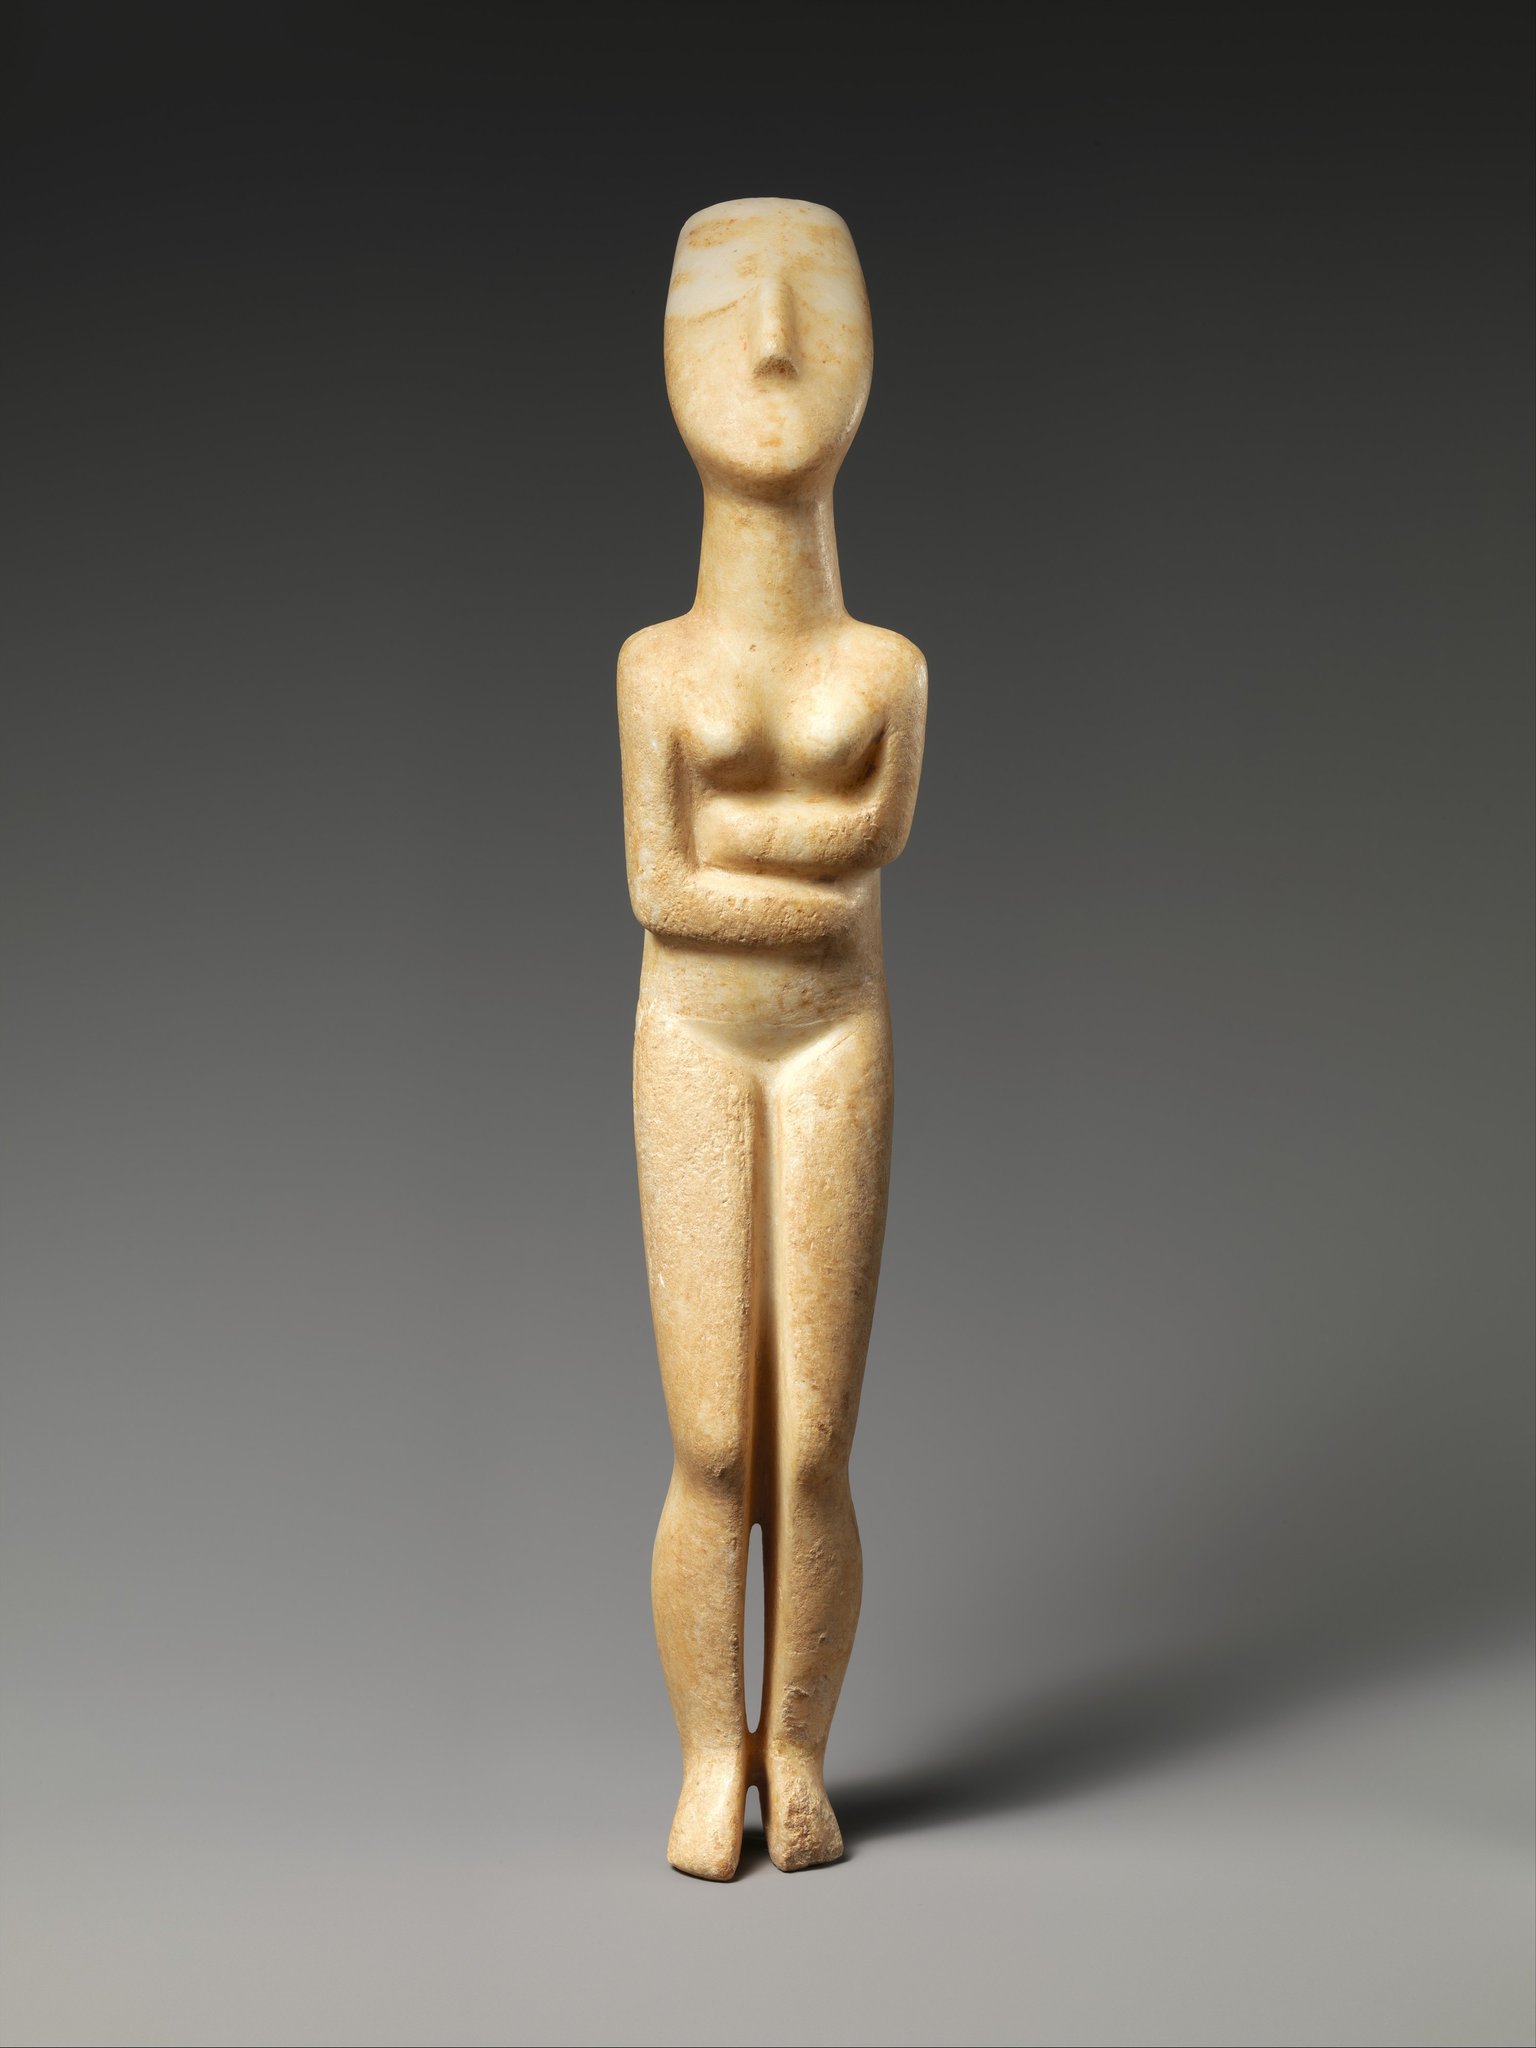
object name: statuette of a woman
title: Marble female figure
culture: cycladic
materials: marble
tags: female nudes